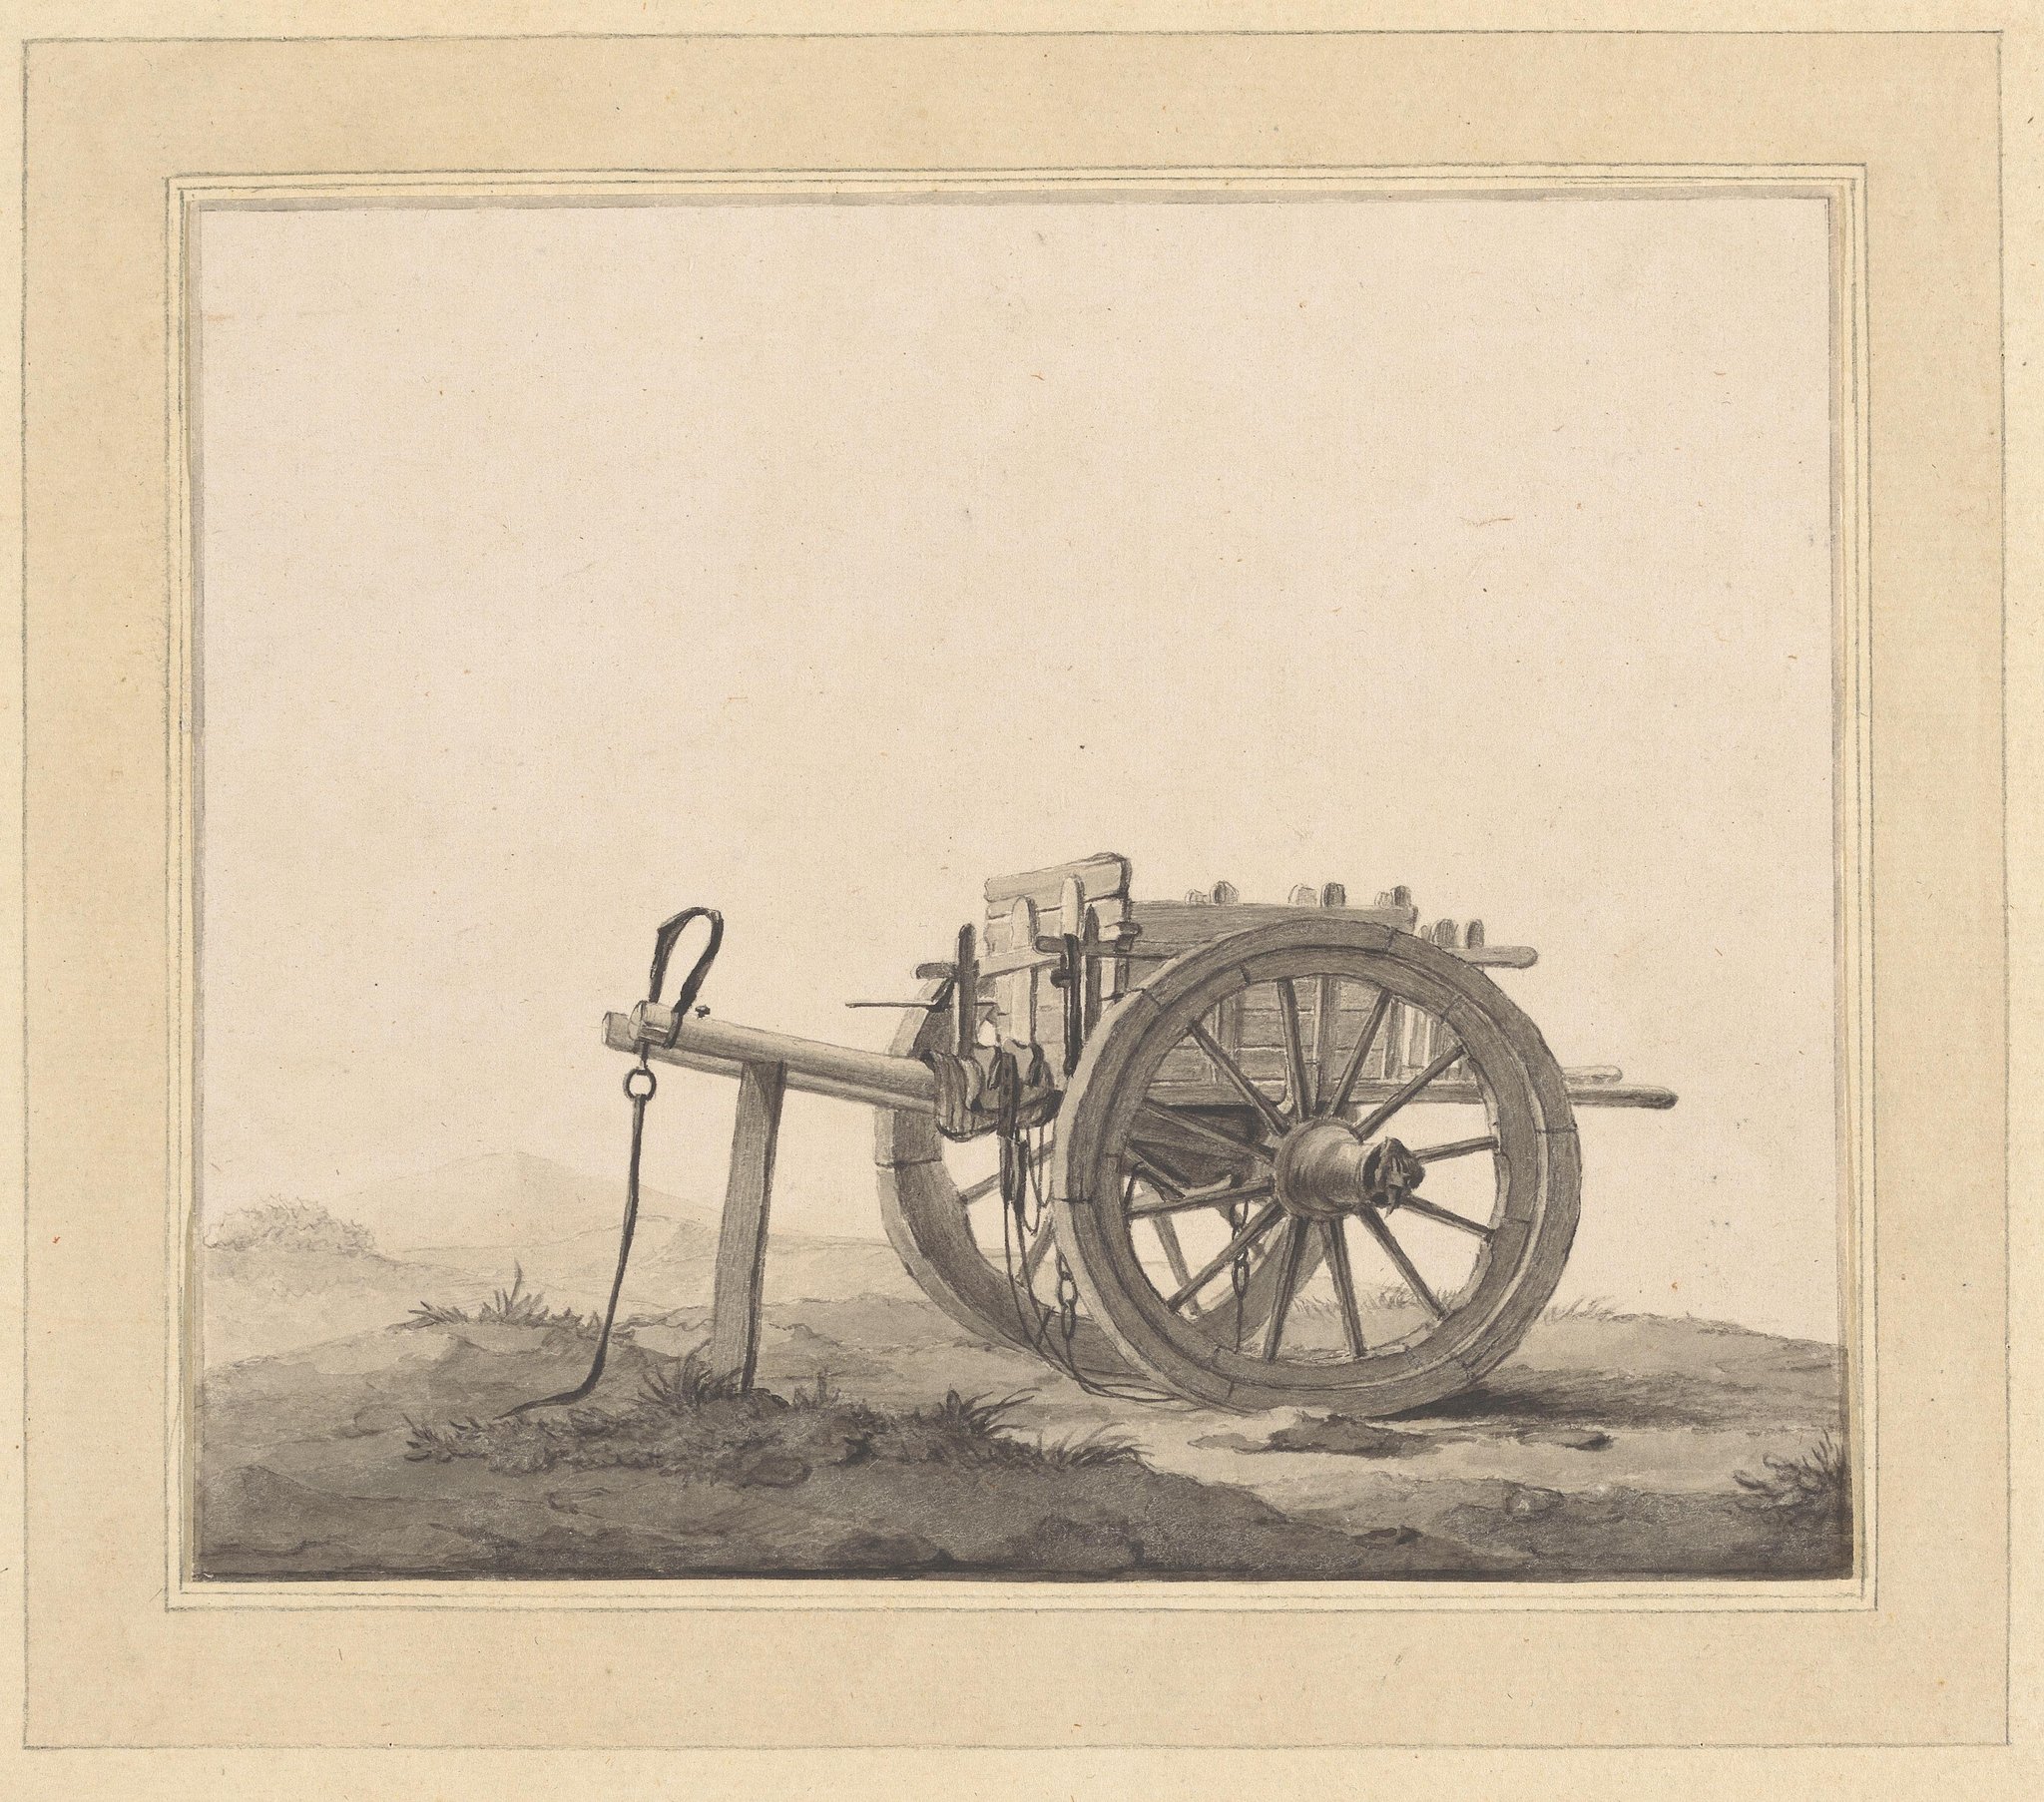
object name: drawing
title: Een schelpenkar in landschap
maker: hendrik van cranenburgh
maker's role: painter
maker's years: 1754-1832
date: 1764-1832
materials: chalk, paper, pencil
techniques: brush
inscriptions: monogram: ‘' H.V.C. ad vivum del.'’, annotation: ‘' Schulpkar, daar men de Schulpen meede van Zee haeld' . en (eigenhandig?) 'H. van Cranenburgh" ..’